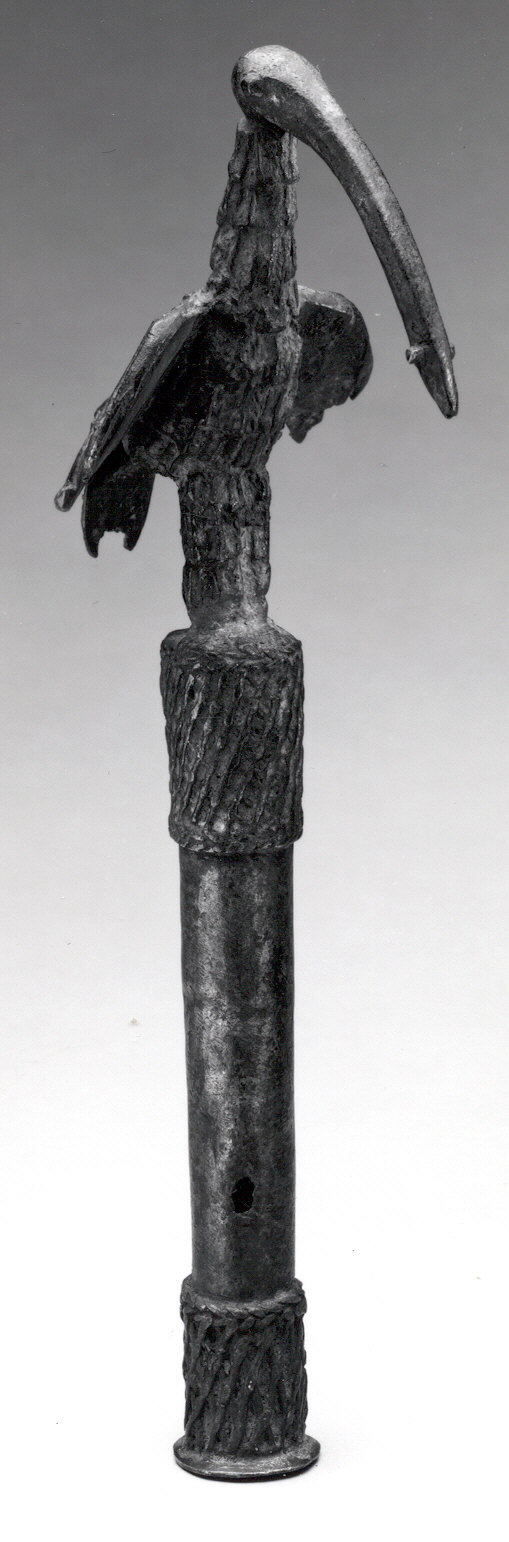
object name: idiophone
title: Idiophone: Bird of Prophecy (ahianmwen-oro)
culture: edo period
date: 1501-1900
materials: brass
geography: nigeria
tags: birds